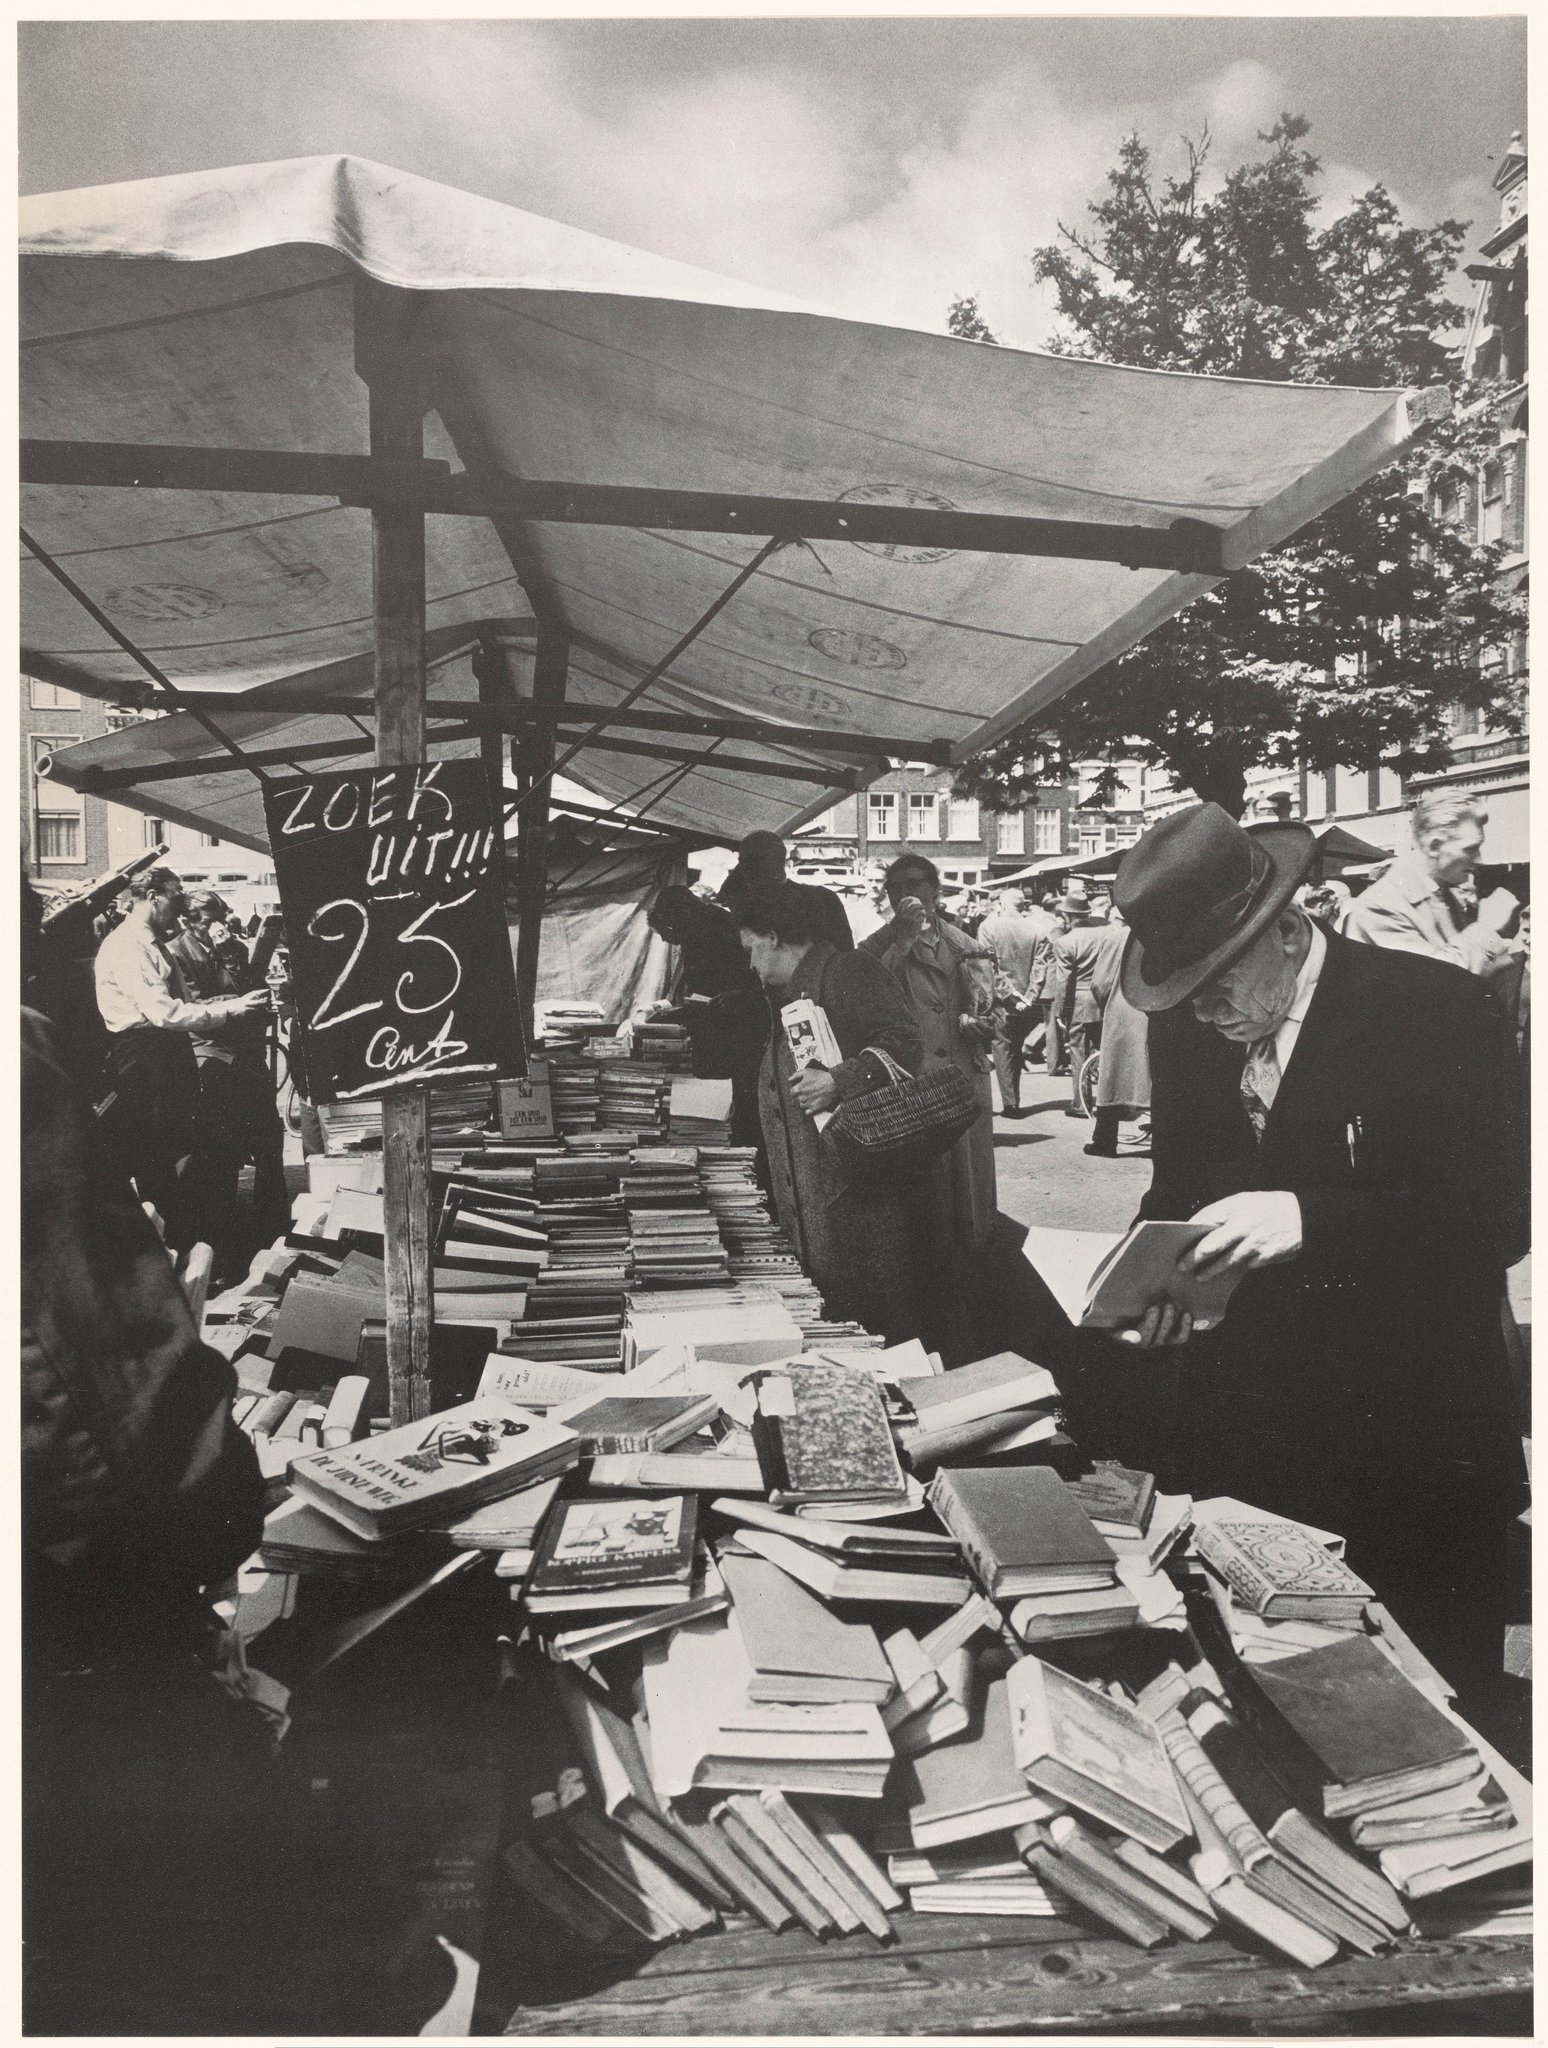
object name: photomechanical print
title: Boekenmarkt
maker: Anonymous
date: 1950-2000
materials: paper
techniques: photochemical processes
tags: book-stall, kiosk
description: Een oude man met een hoed voor een boekenkraam met een boek in zijn handen. Aan de kraam hangt een bord: 'Zoek uit!!! 25 cent'.